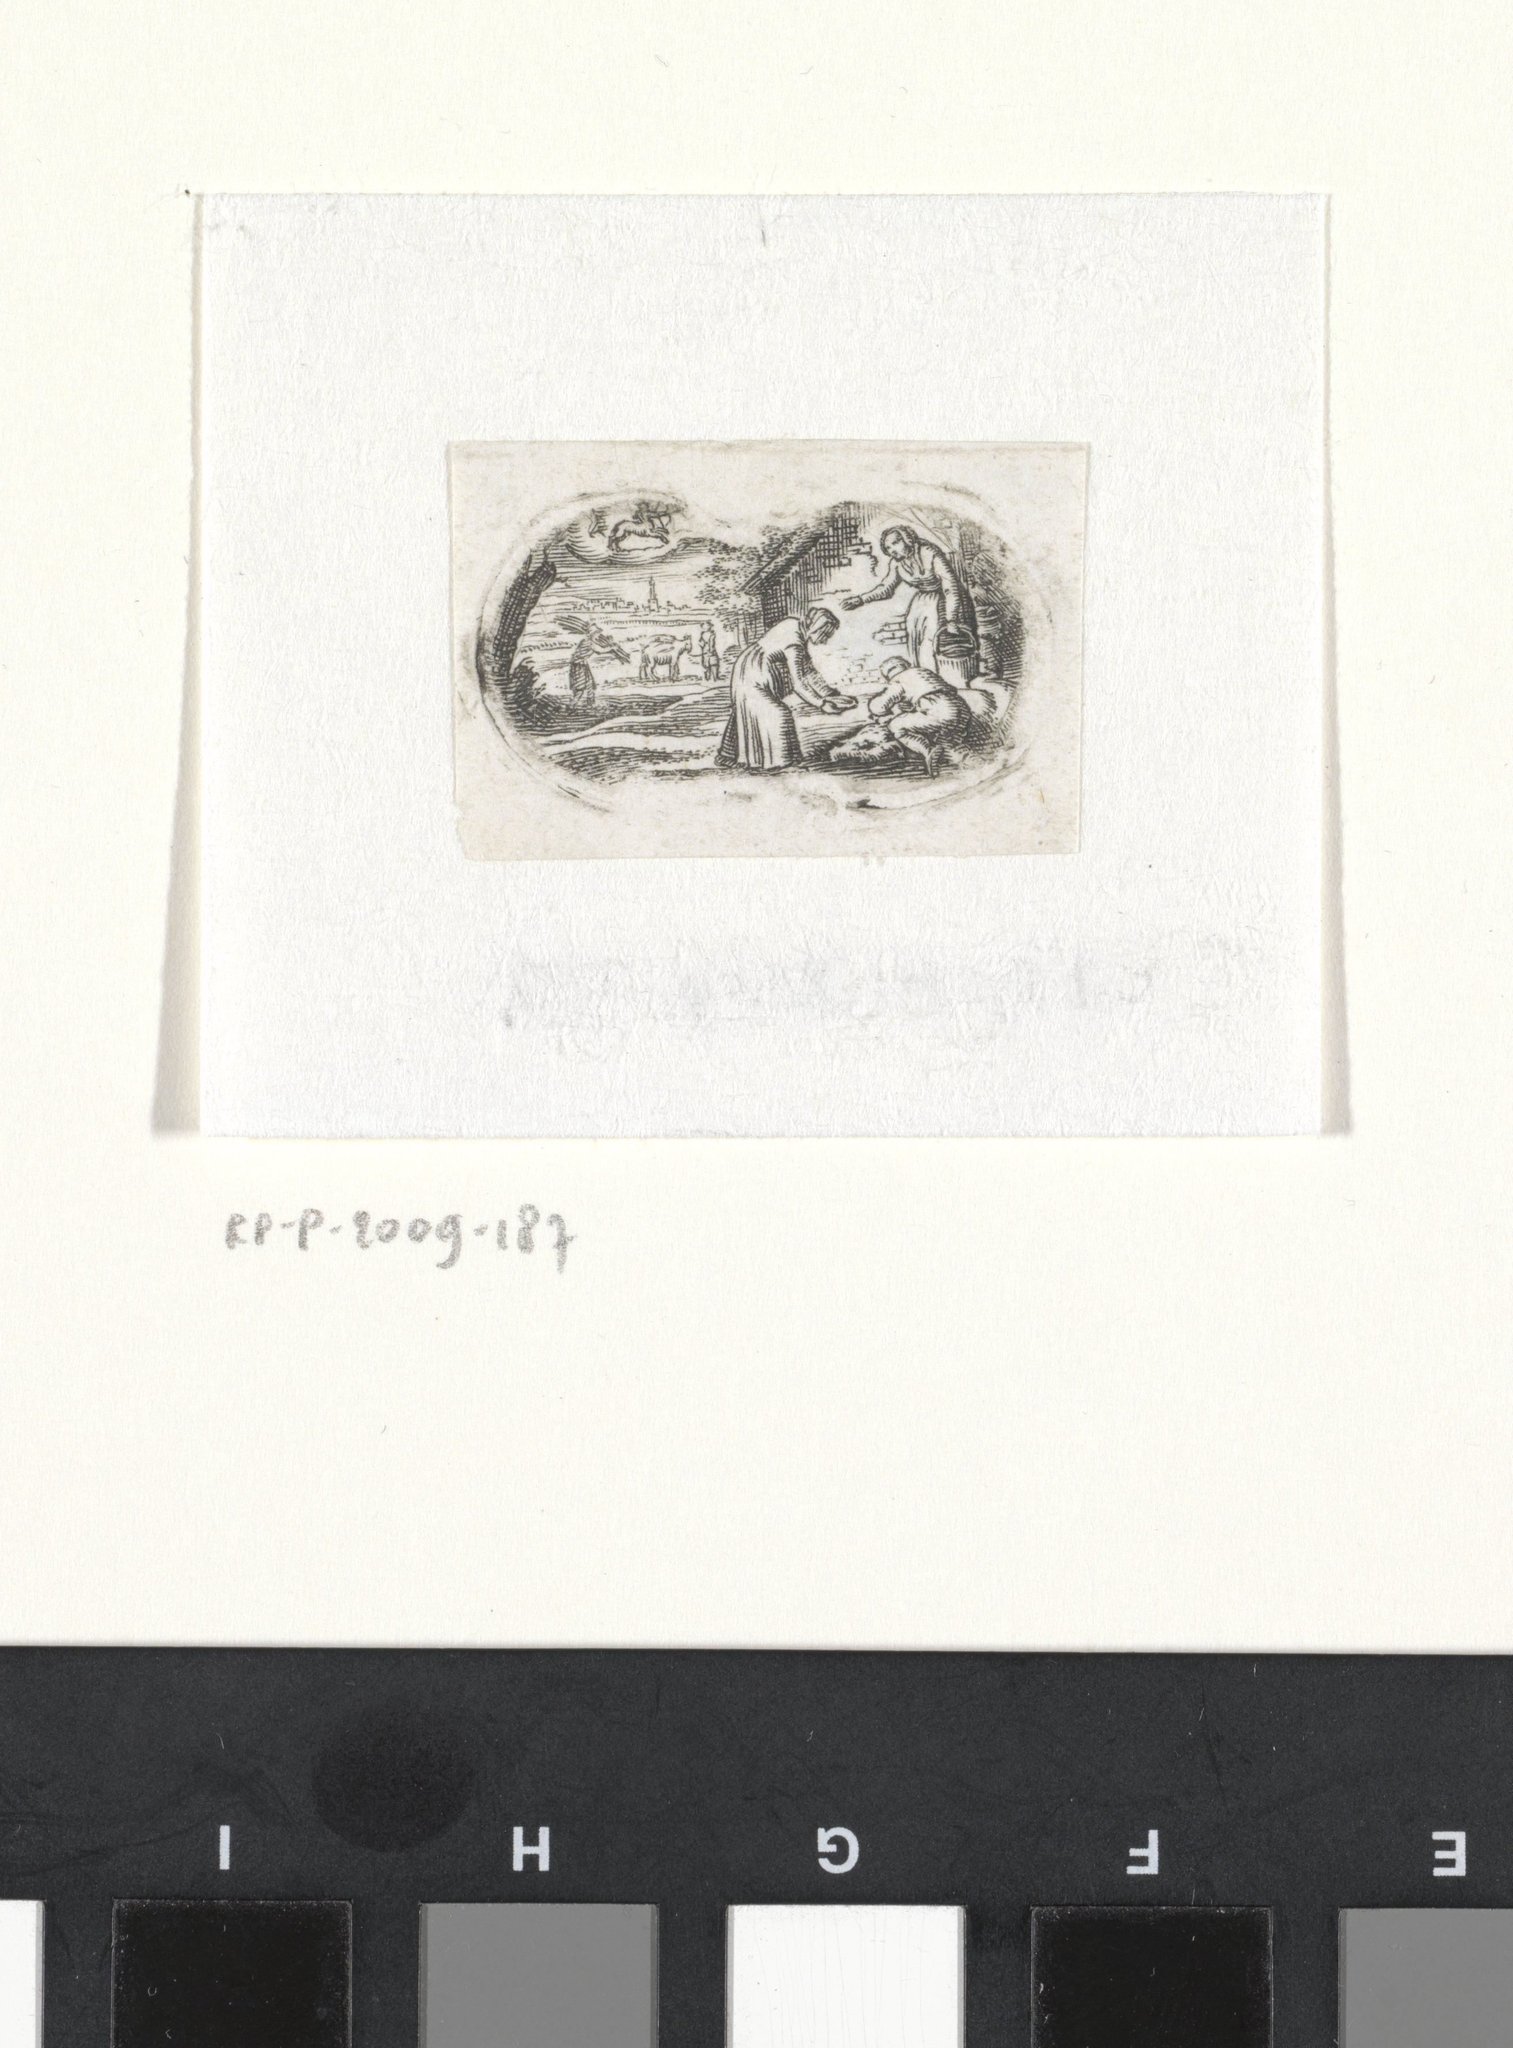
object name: print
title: November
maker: Anonymous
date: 1625-1700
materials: paper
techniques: engraving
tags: november and its 'labours', sagittarius (zodiacal sign of november), slaughtered ox or pig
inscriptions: collector's mark: Lugt 2228, collector's mark: Lugt 2760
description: Menselijke bezigheden in de maand november. Landschap met rechts een man die een varken slacht. Linksboven het sterrenbeeld Boogschutter.